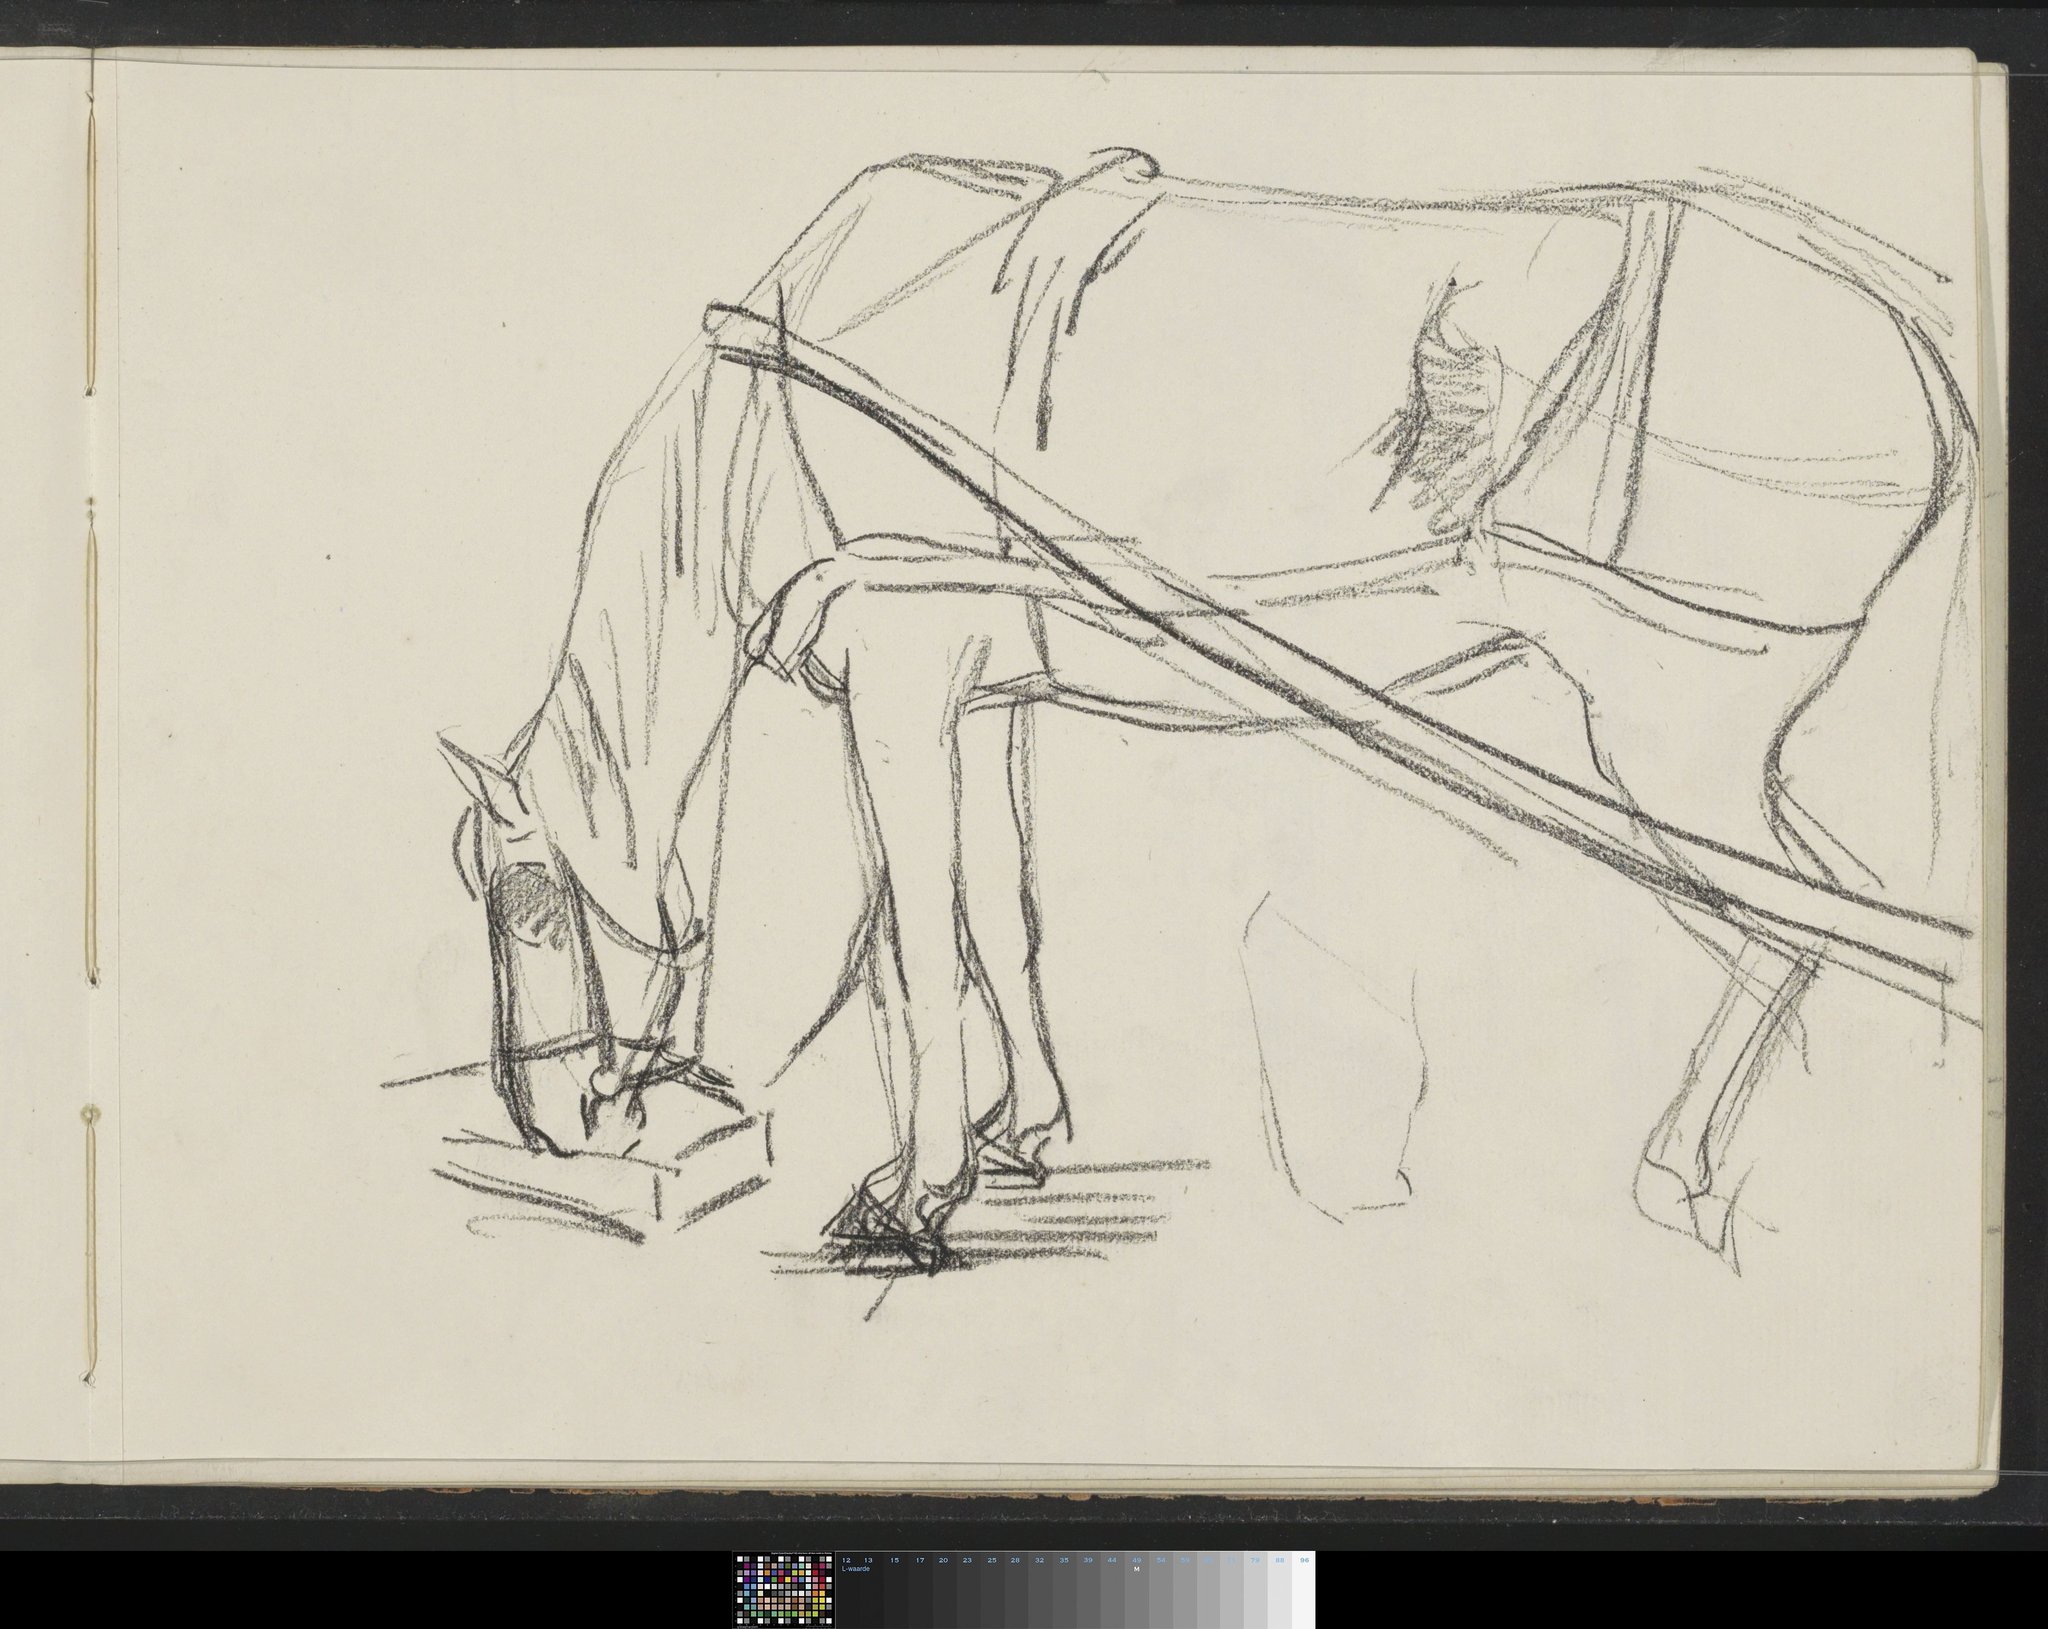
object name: sketchbook leaf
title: Trekpaard dat uit een bak eet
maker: ferdinand oldewelt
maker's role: draughtsman, print maker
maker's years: 1857-1935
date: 1904-1912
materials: chalk, paper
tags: harness, horse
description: Blad 7 recto uit een schetsboek met 27 bladen.